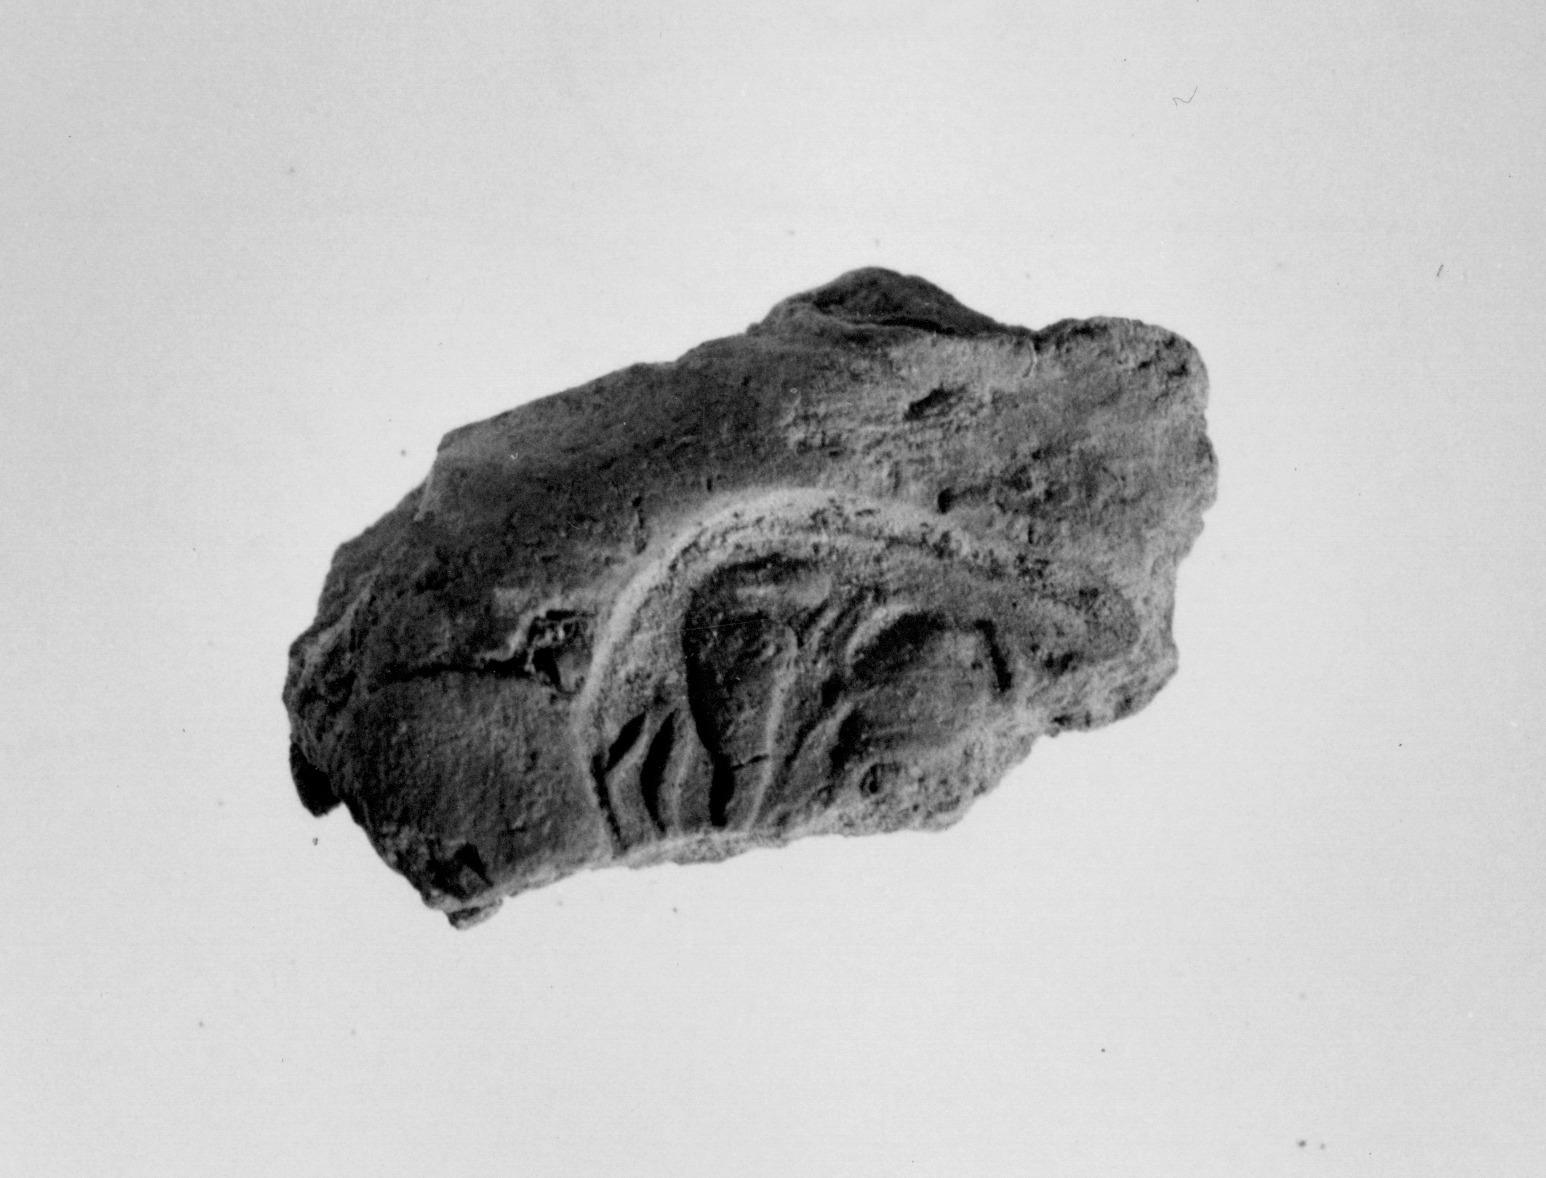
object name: sealing, cobra, scarab, uraeus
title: Document Sealing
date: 1390-1352 BCE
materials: mud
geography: egypt